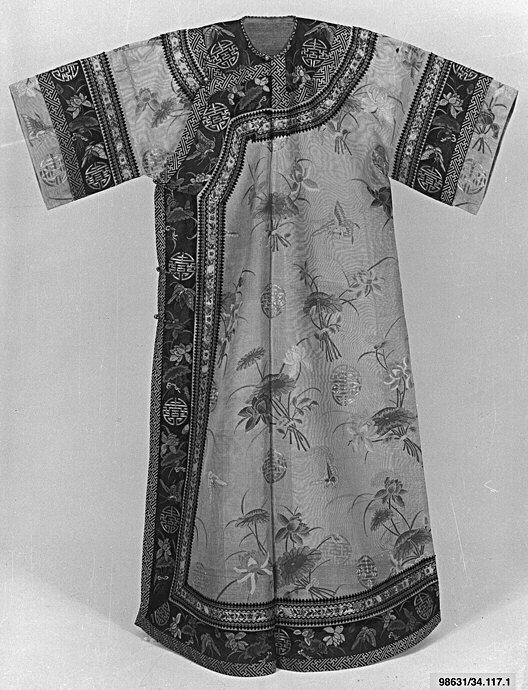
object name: woman's robe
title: Woman’s Robe with Lotus Flowers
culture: chinese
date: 1701-1800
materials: textile, silk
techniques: embroidery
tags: lotuses